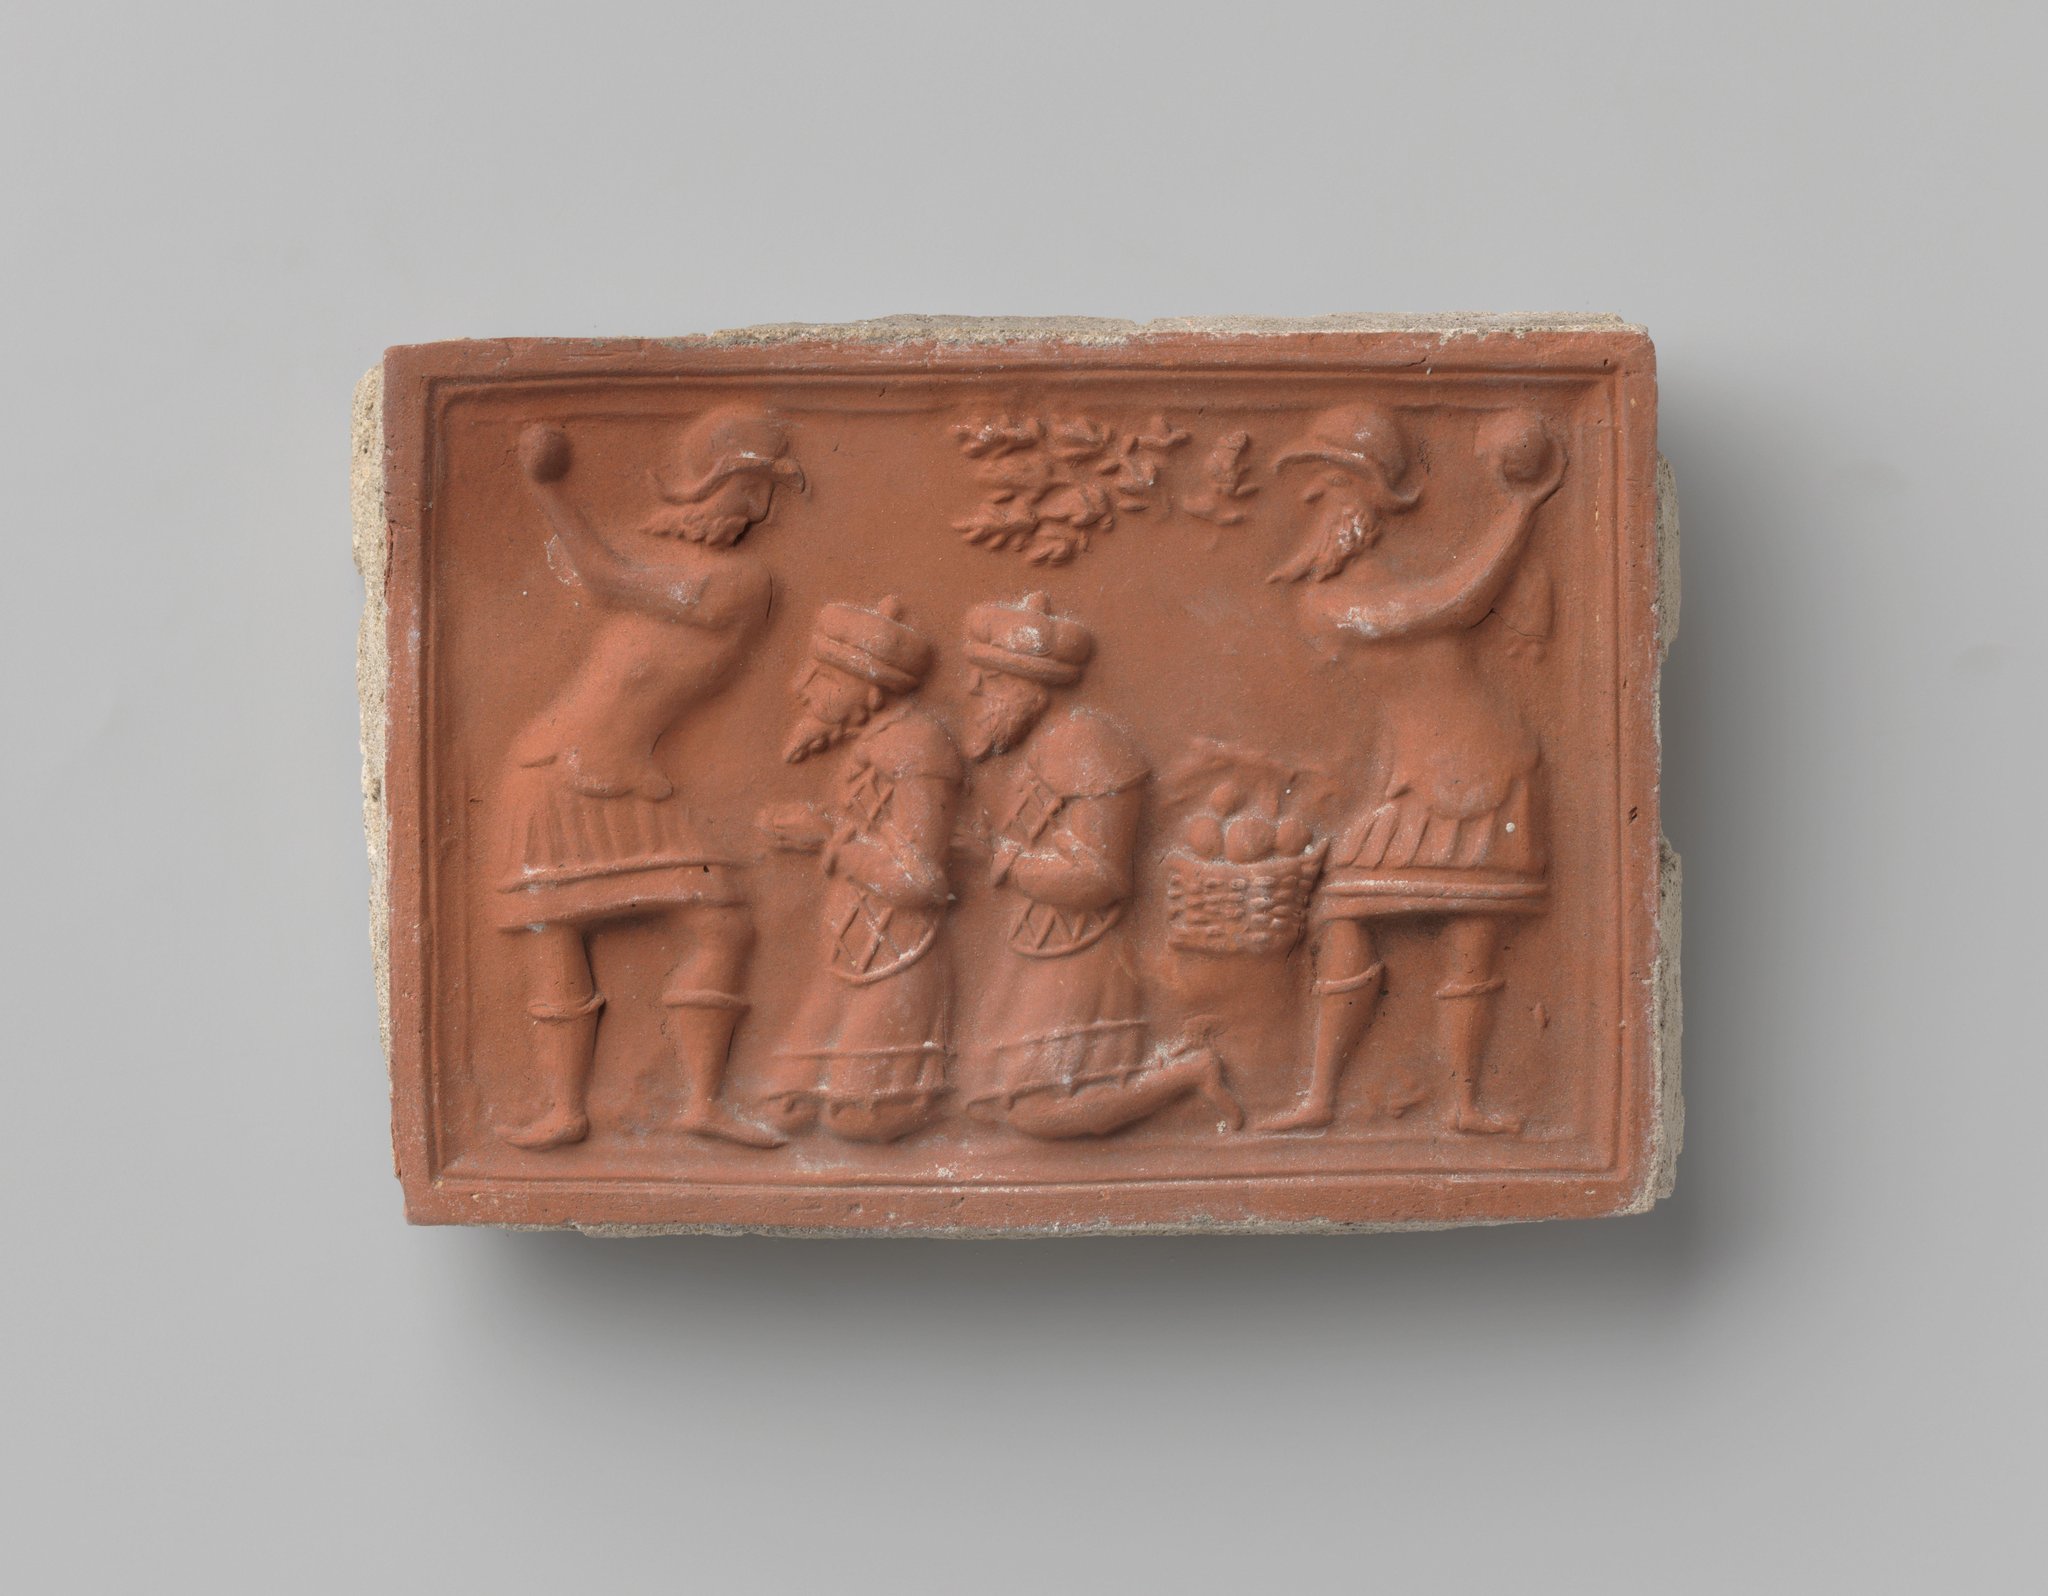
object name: hearthstone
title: Haardsteen met voorstelling van de beide ouderlingen uit de geschiedenis van Suzanna, die door twee soldaten worden gestenigd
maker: Anonymous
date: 1875-1900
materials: earthenware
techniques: printing, firing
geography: netherlands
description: Haardsteen met voorstelling van de beide ouderlingen uit de geschiedenis van Suzanna, die door twee soldaten worden gestenigd. Op de achtergrond een mand met stenen en een boom.